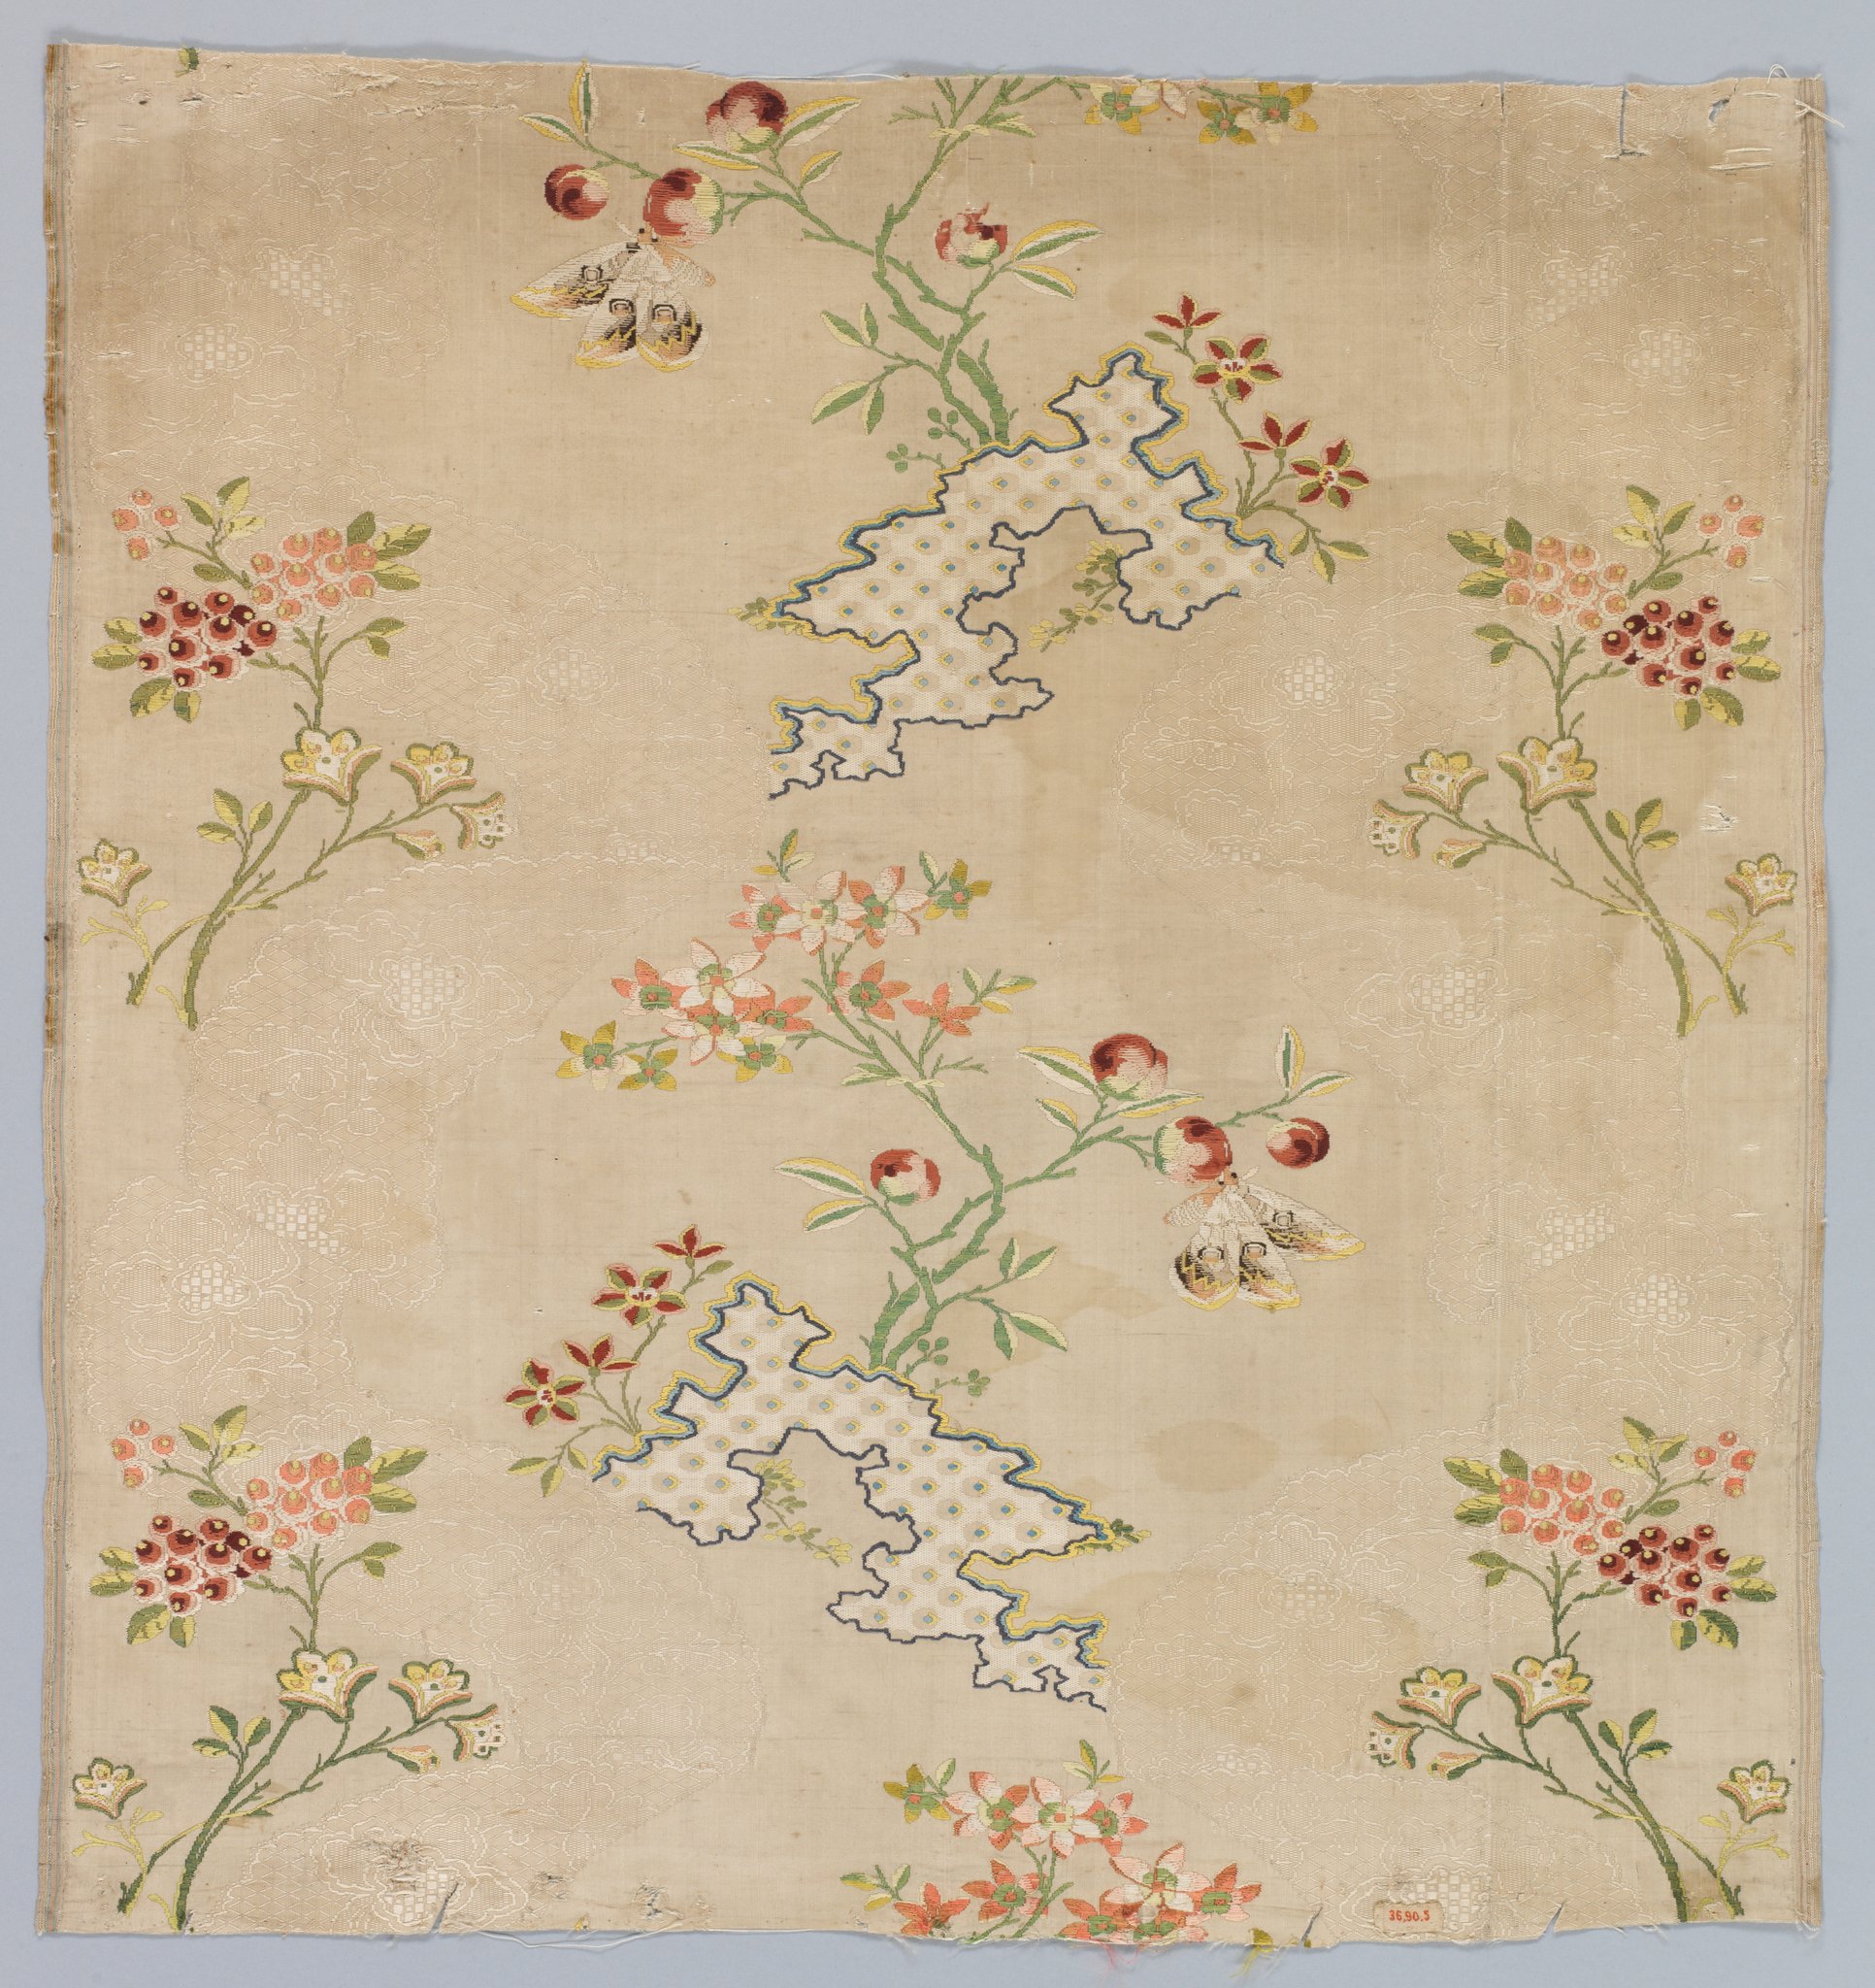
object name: piece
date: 1750-1760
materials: silk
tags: butterflies,flowers,leaves